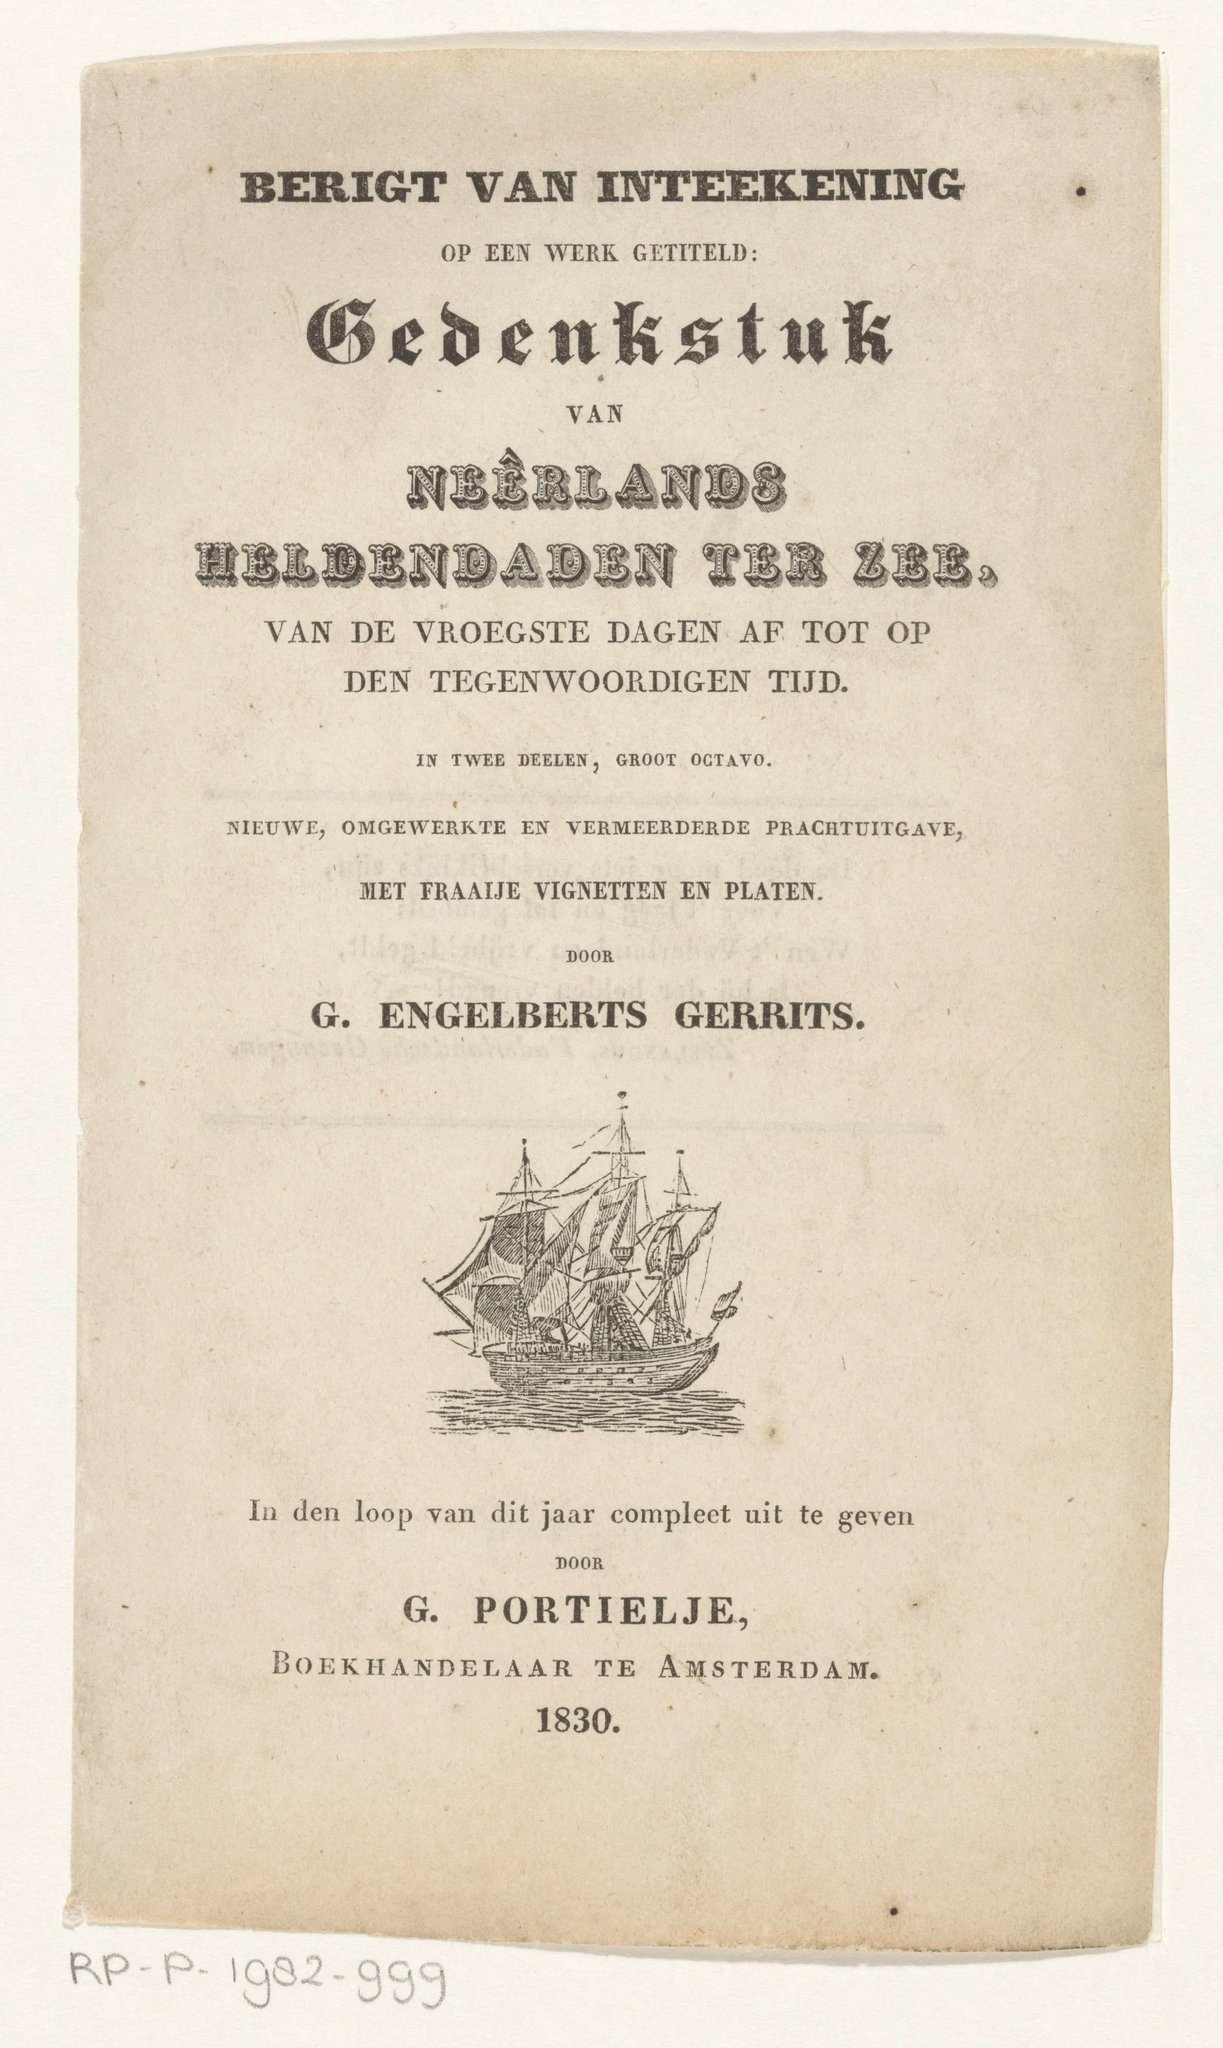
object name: titelblad, titelpagina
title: Schip op zee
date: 1830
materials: paper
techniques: engraving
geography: amsterdam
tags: ships (in general)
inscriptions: collector's mark: Lugt 2760, collector's mark: Lugt 2228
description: Titelpagina voor: Engelberts Gerrits, G. Berigt van inteekening op een werk getiteld: Gedenkstuk van Neêrlands heldendaden ter zee. Amsterdam: Portielje, Gerrit, 1830.